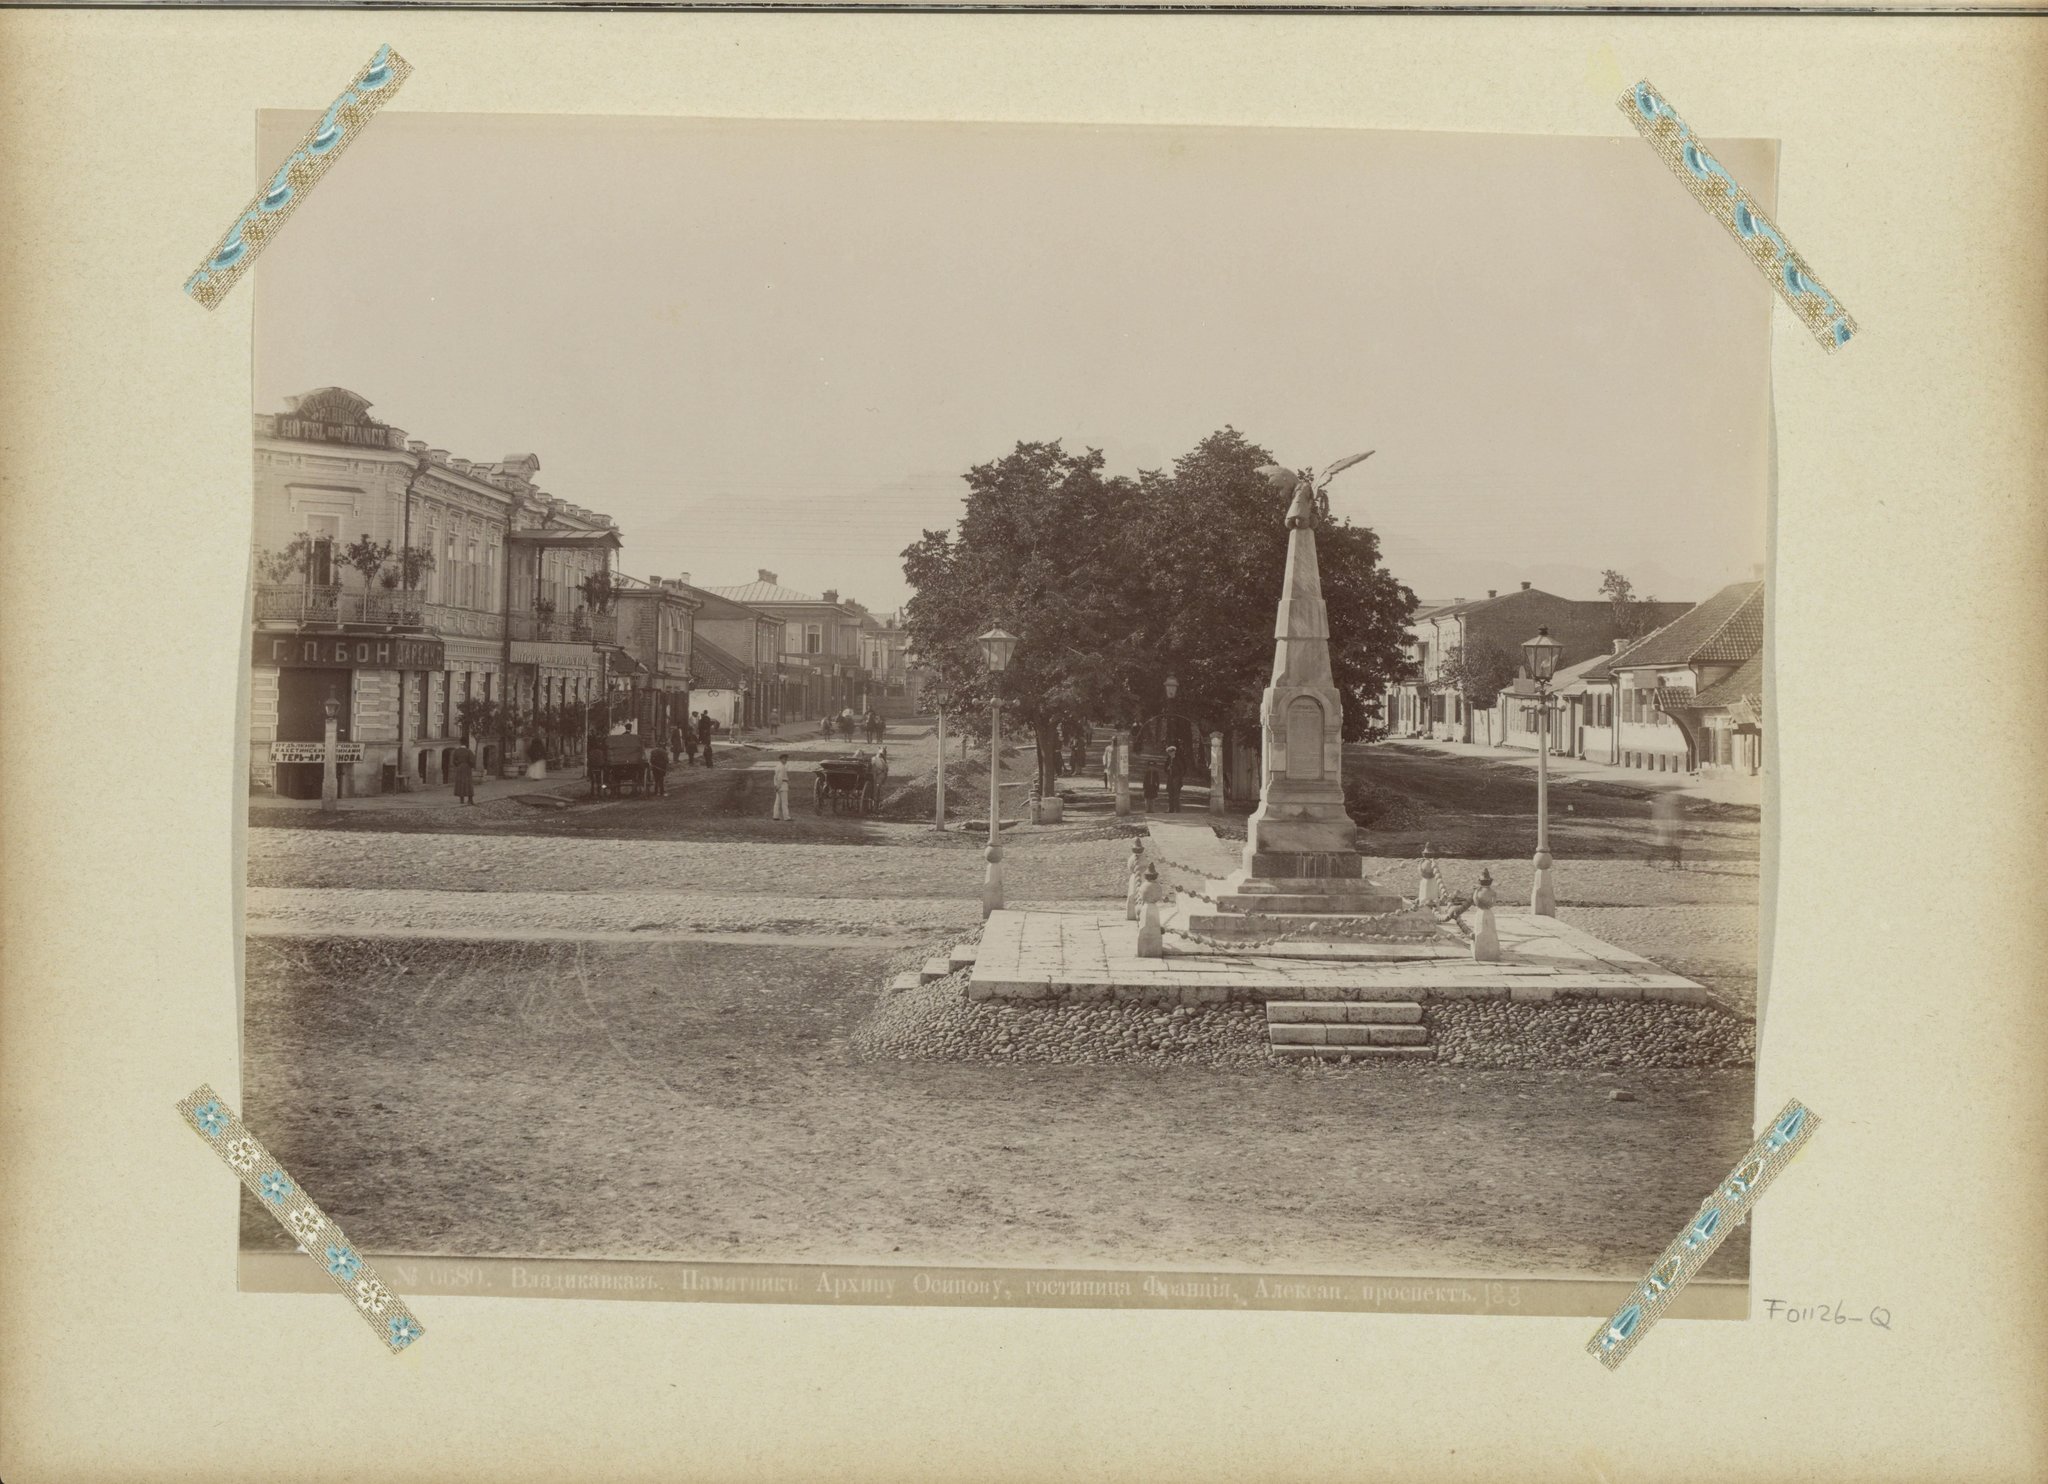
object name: photograph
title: Alexander Prospekt met monument in Vladikavkaz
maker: Anonymous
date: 1890-1900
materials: photographic support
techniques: albumen print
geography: vladikavkaz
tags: monument, statue, square, place, circus, etc. (+ city(-scape) with figures, staffage)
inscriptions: number: ‘188’, number: ‘6680’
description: Onderdeel van Fotoalbum met opnames van bezienswaardigheden in Georgië, Sint-Petersburg en Moskou.